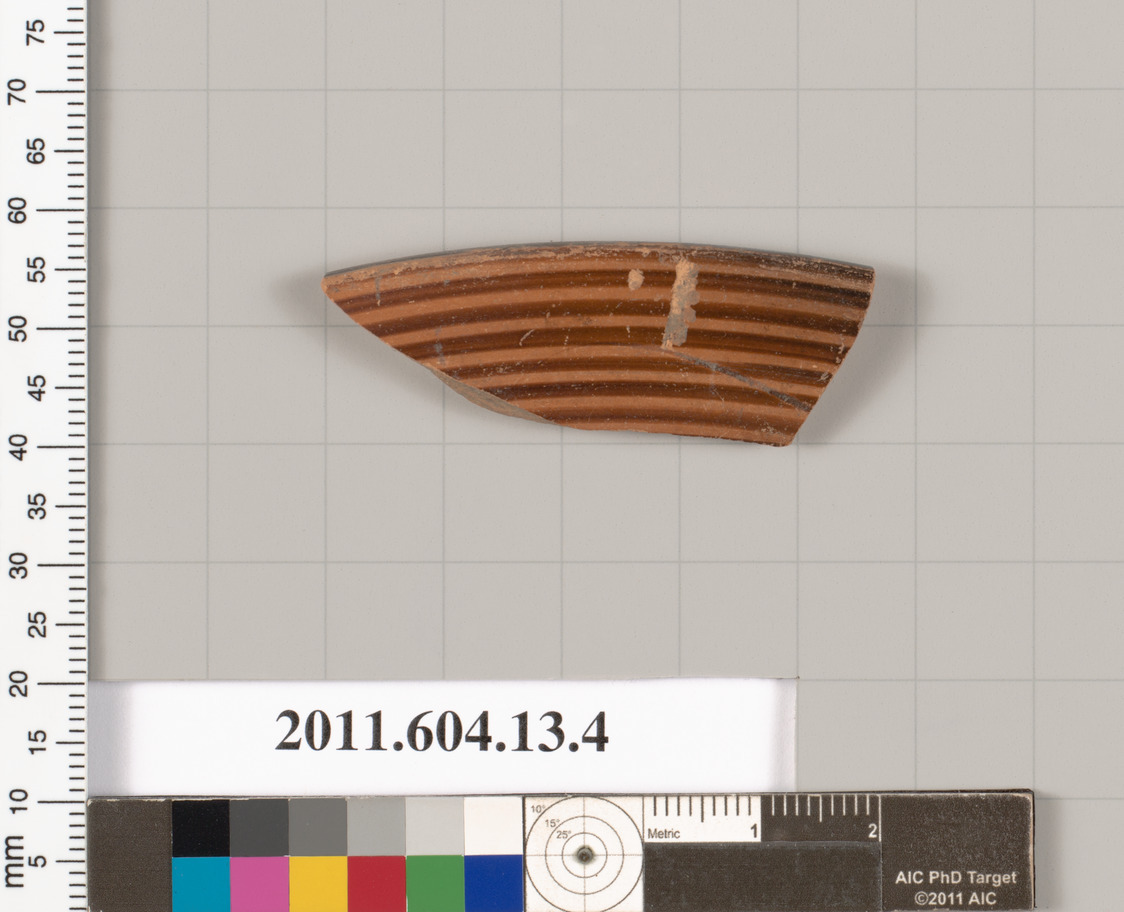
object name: fragment of a bowl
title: Terracotta fragment rim of a bowl?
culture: east greek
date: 600-501 BCE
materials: terracotta